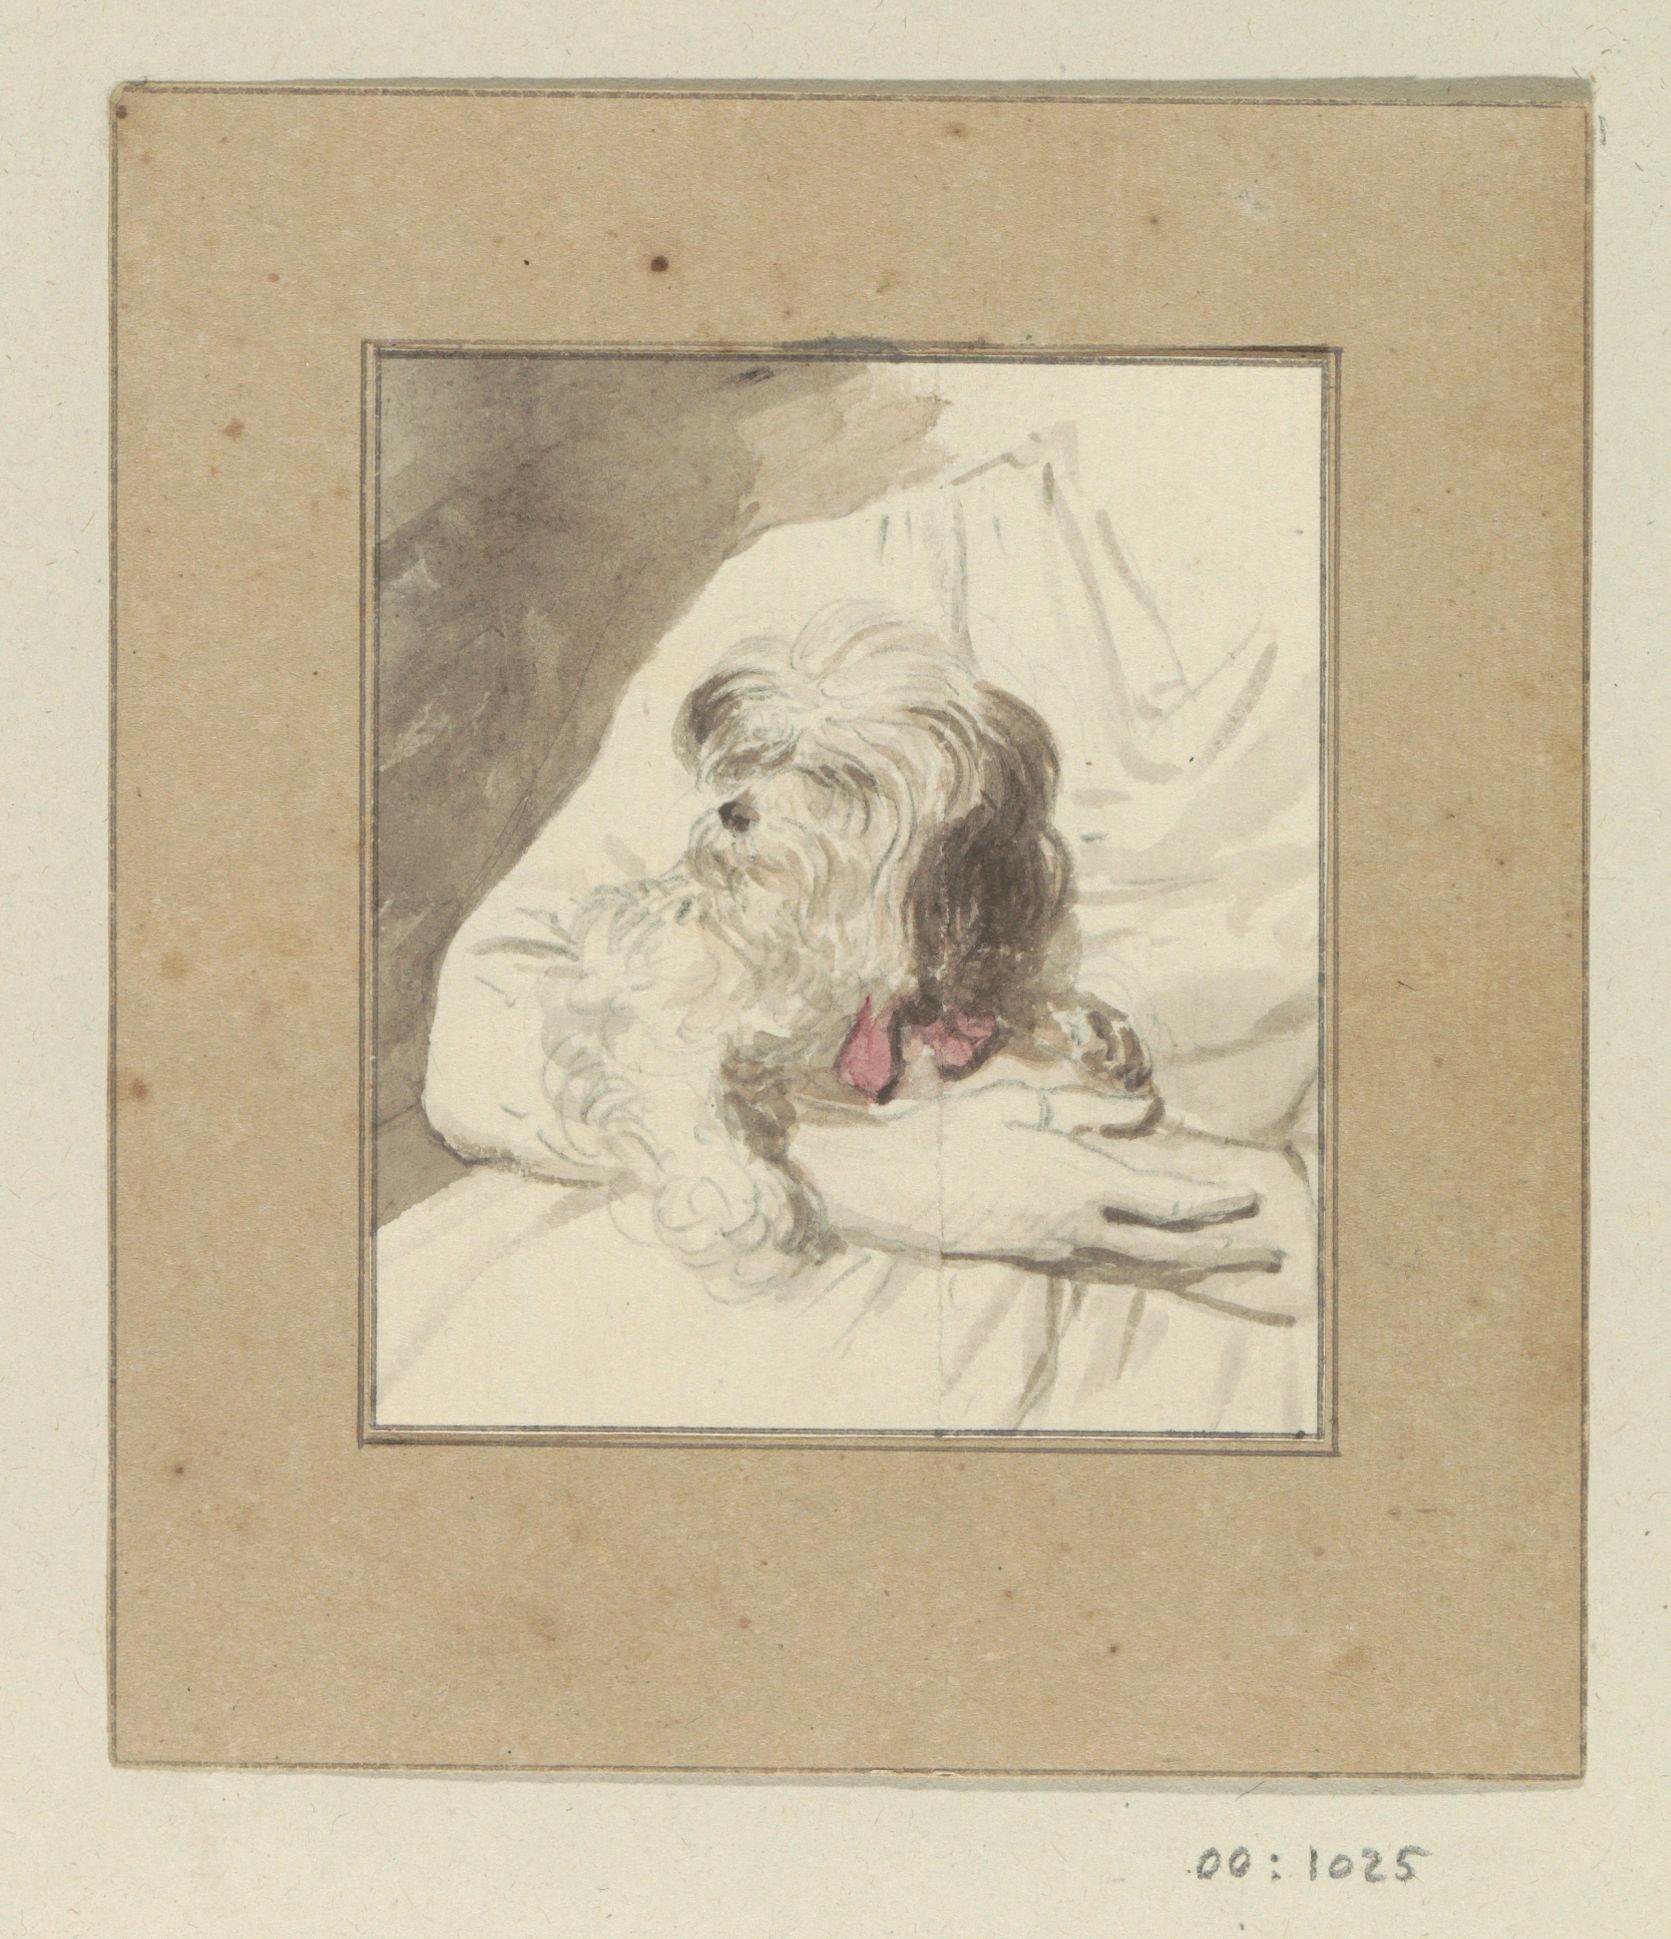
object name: drawing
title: Hond op schoot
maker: jurriaan andriessen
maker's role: draughtsman, painter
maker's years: 1742-1819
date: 1760-1819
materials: paint, paper, pencil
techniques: brush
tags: dog